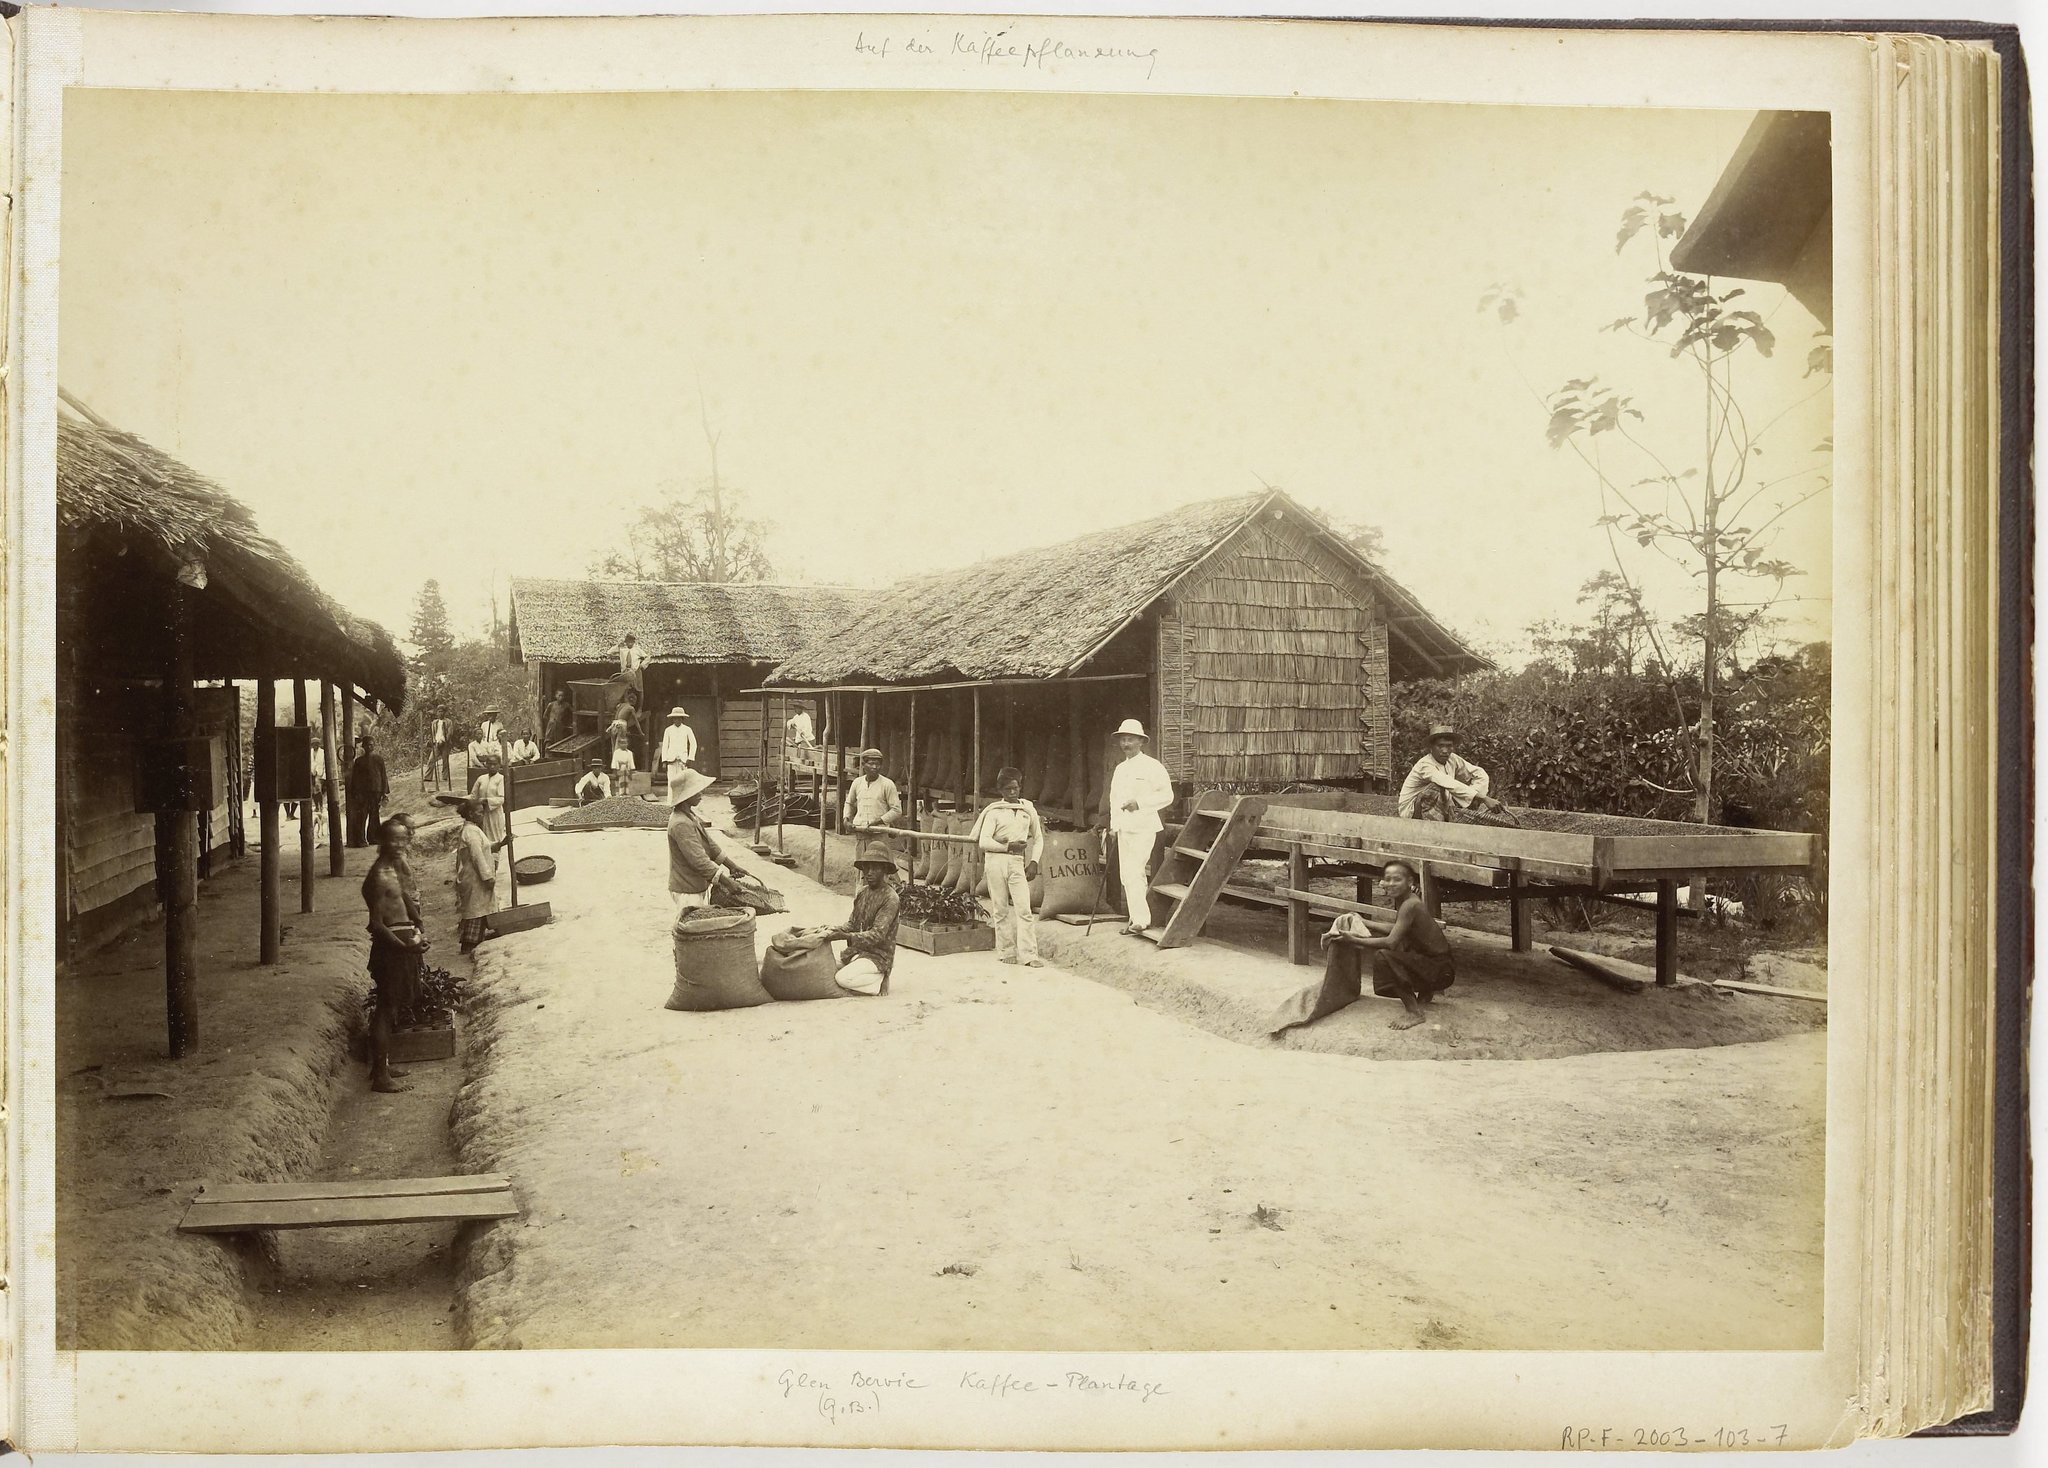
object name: photograph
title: Op de koffieplantage Glen bervie (G.B), Langkat Sumatra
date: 1900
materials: cardboard, paper, photographic support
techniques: albumen print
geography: bindjai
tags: sumatra